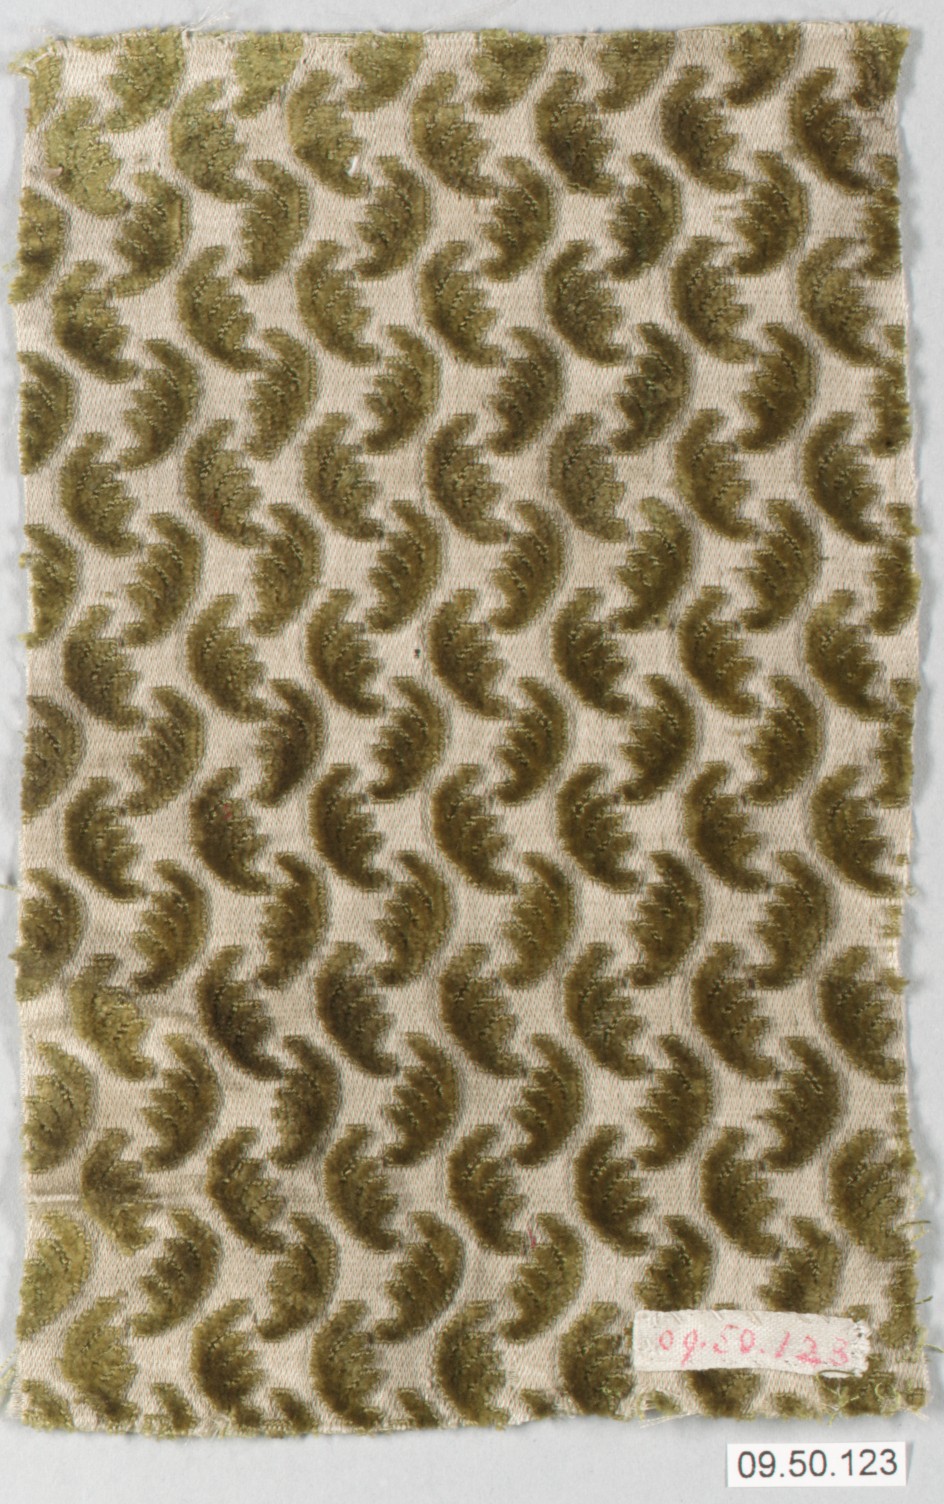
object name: piece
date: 1501-1700